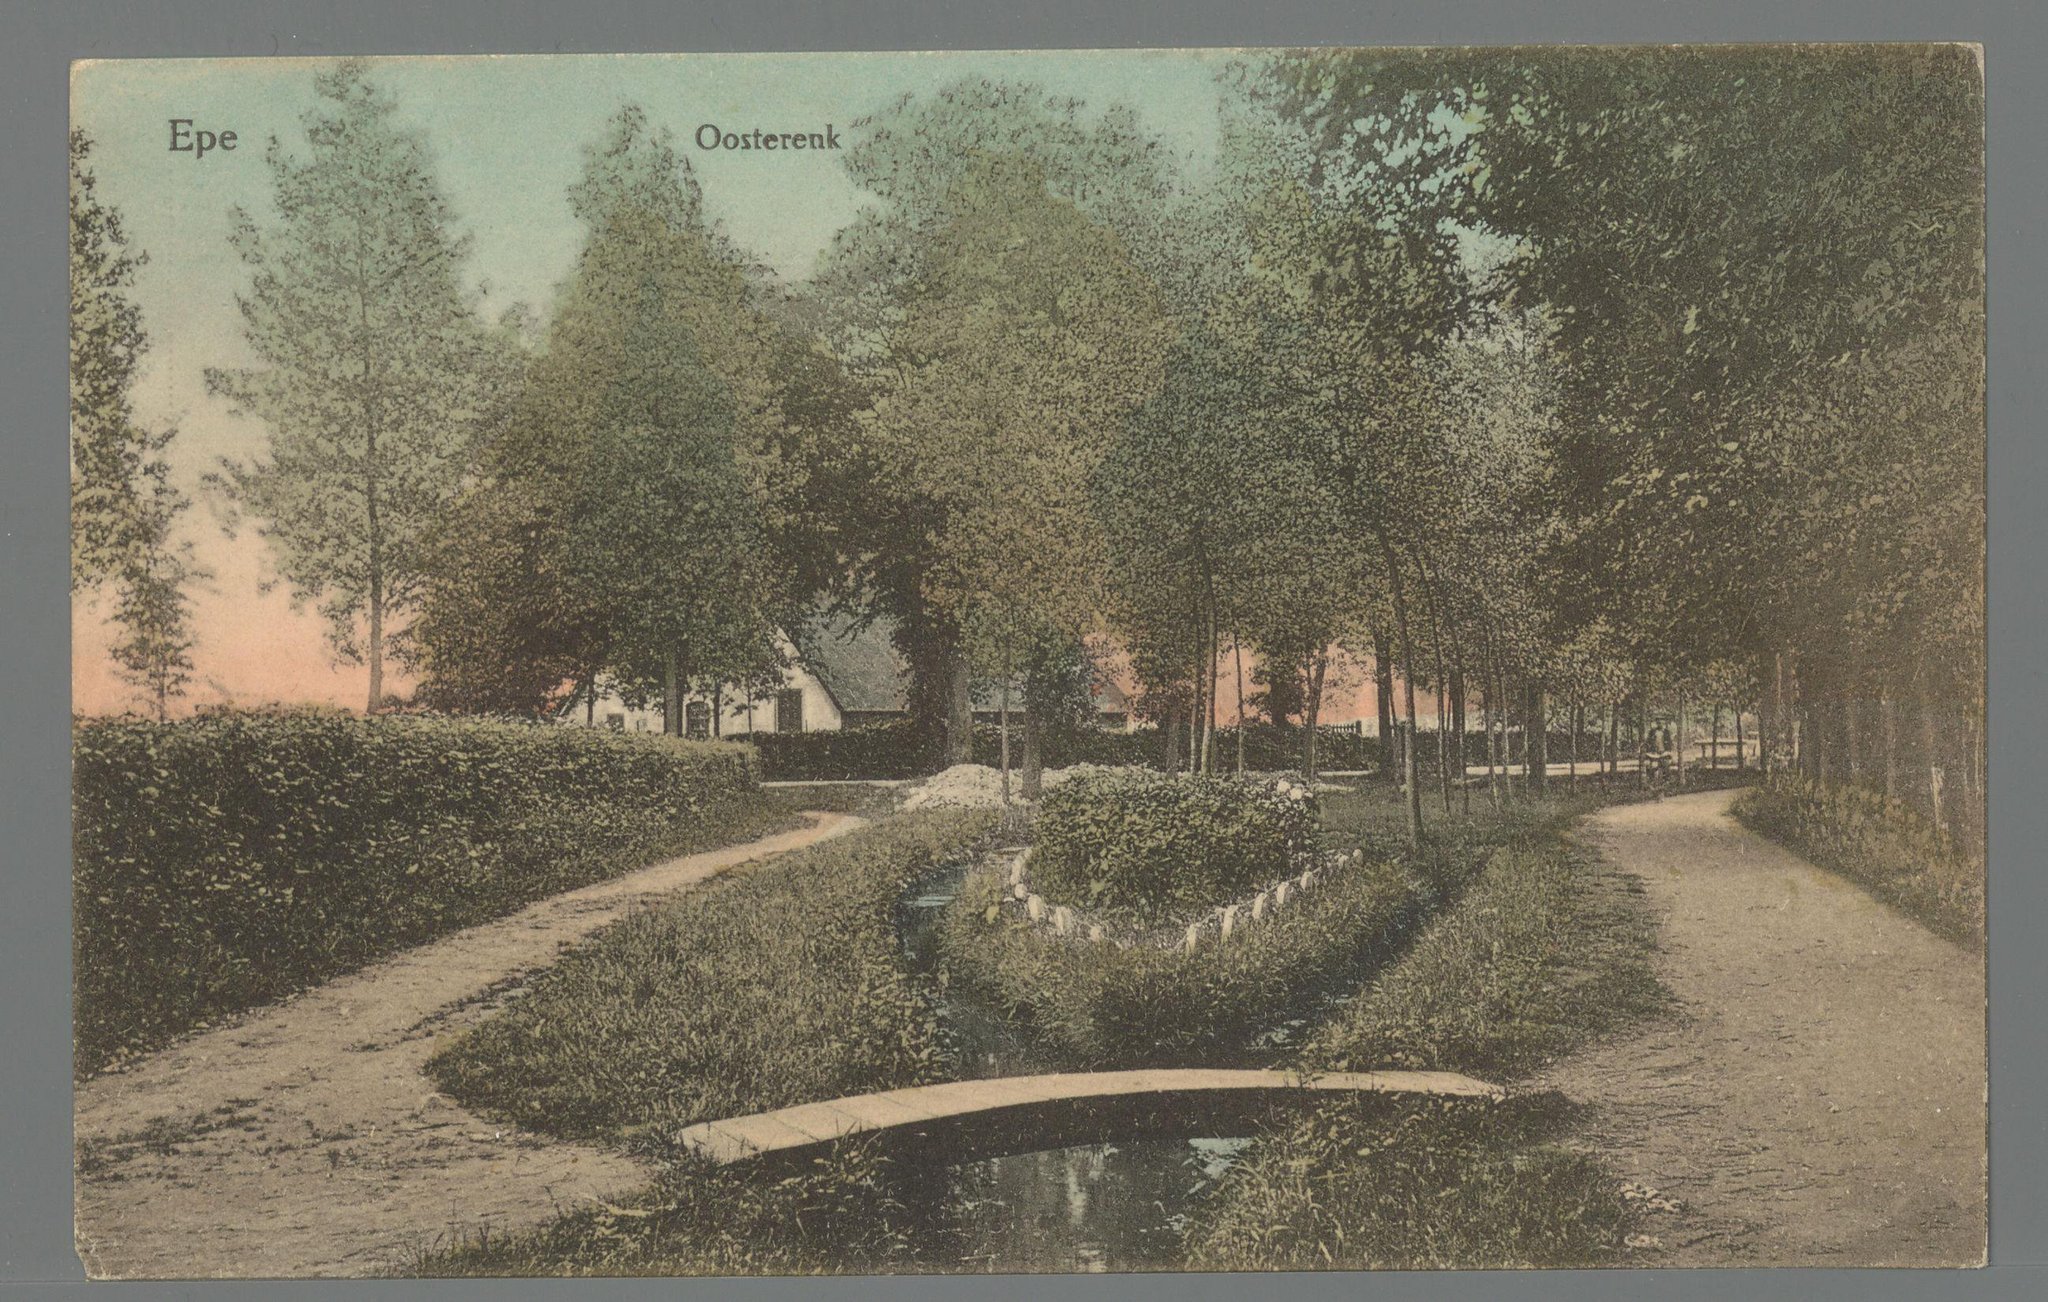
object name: photomechanical print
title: Epe. Oosterenk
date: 1908-1930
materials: cardboard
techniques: photograph, hand coloring, writing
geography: epe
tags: road, path